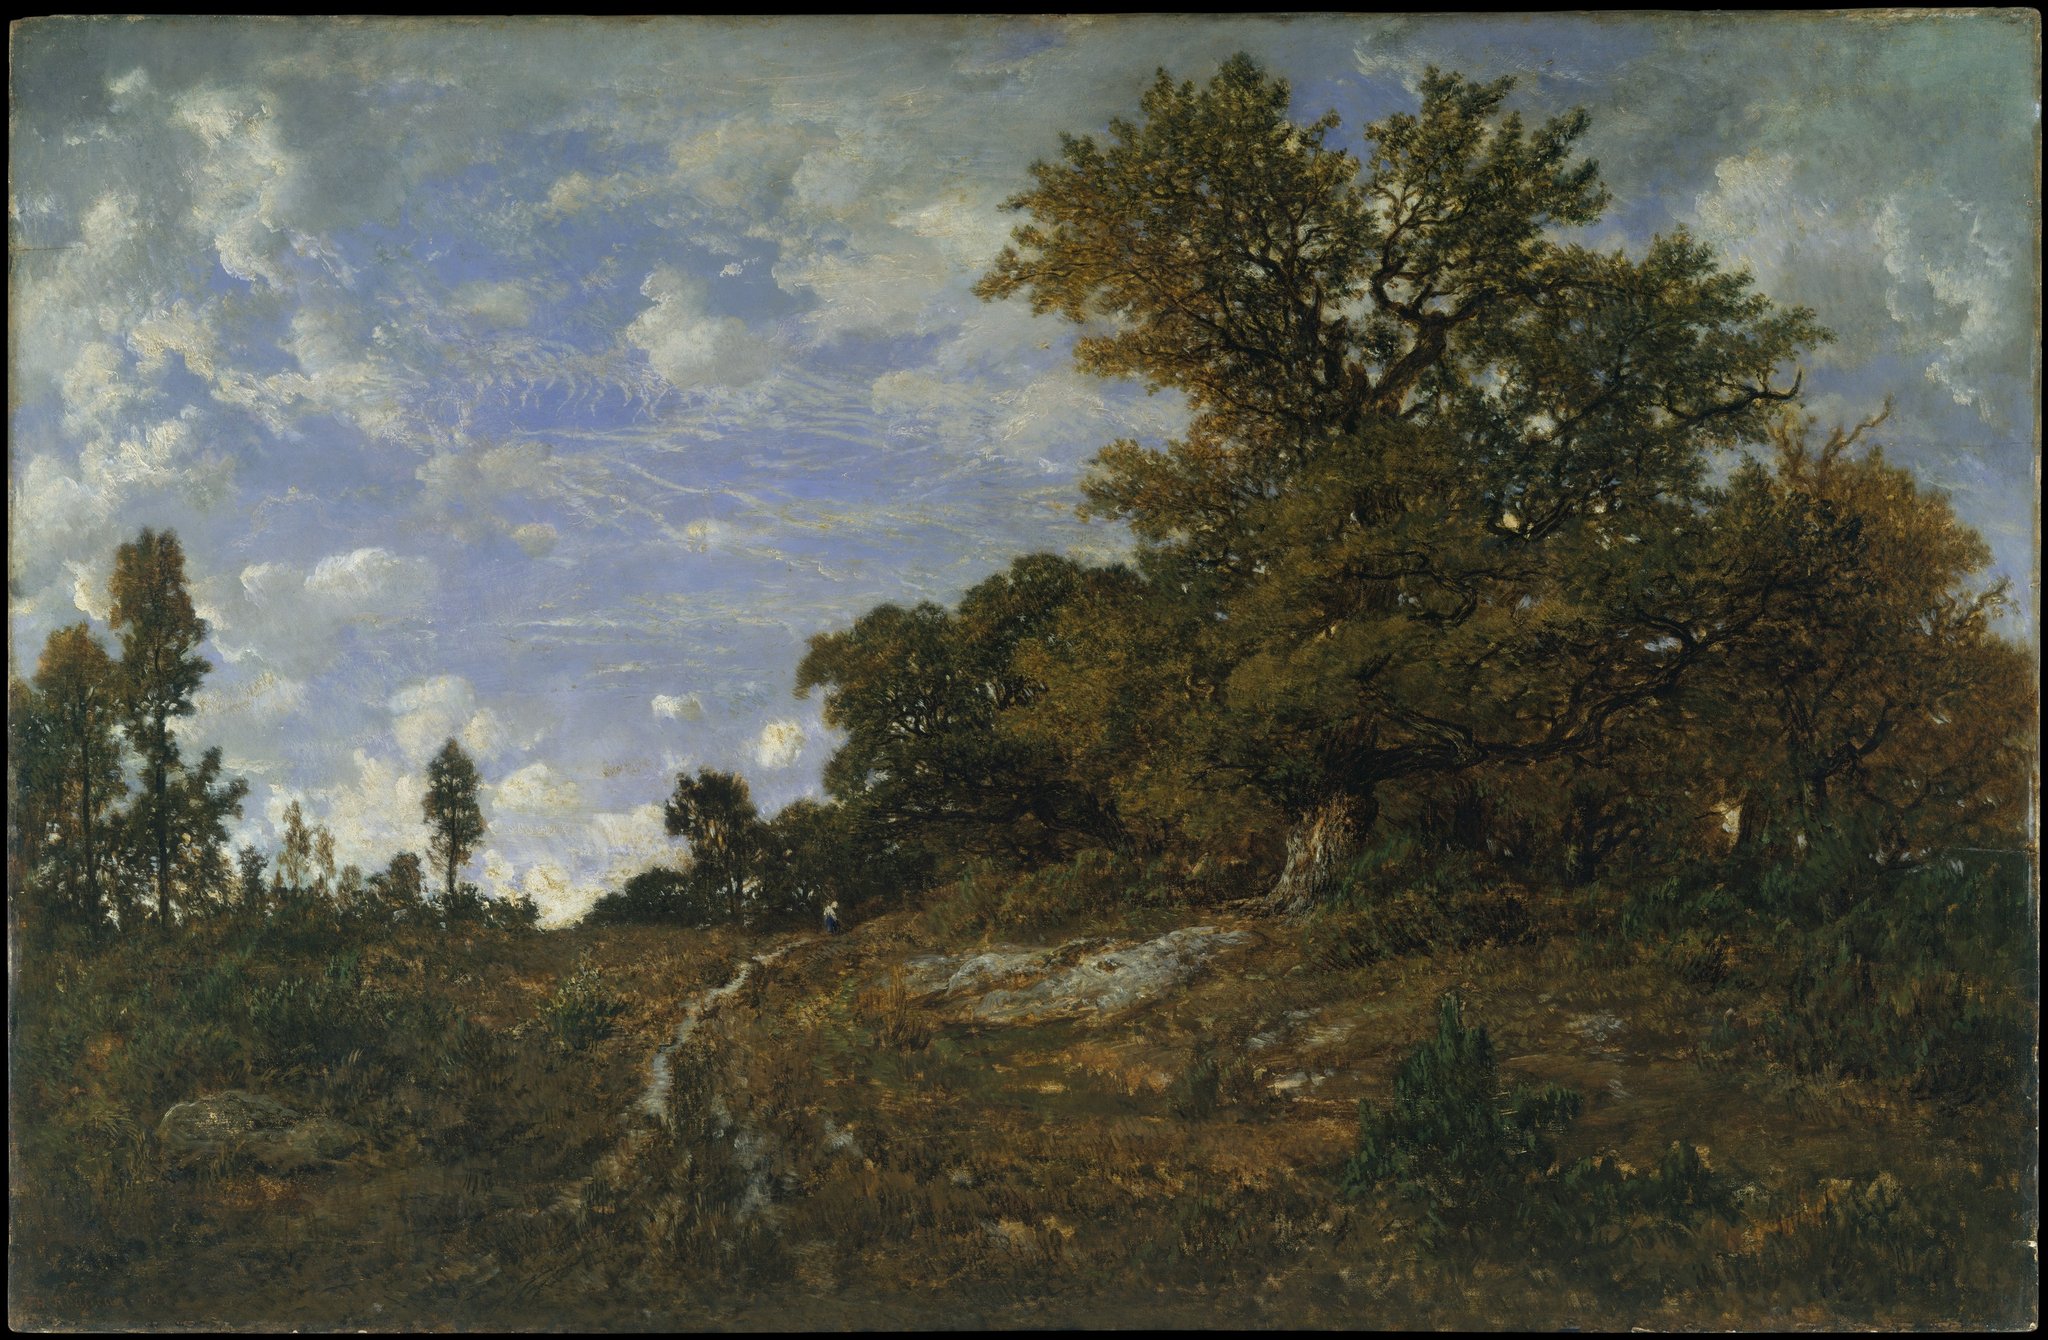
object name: painting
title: The Edge of the Woods at Monts-Girard, Fontainebleau Forest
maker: théodore rousseau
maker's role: artist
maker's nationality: french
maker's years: 1812-1867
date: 1852-1854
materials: oil, wood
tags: forests,landscapes